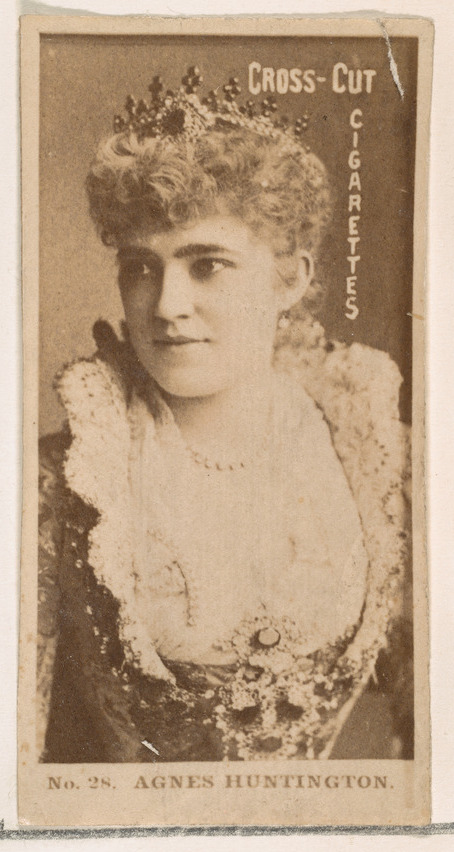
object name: print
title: Card Number 28, Agnes Huntington, from the Actors and Actresses series (N145-2) issued by Duke Sons & Co. to promote Cross Cut Cigarettes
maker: w. duke, sons & co.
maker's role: publisher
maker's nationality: american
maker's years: 1870-1920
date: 1880-1889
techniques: albumen silver print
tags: portraits,women,actresses